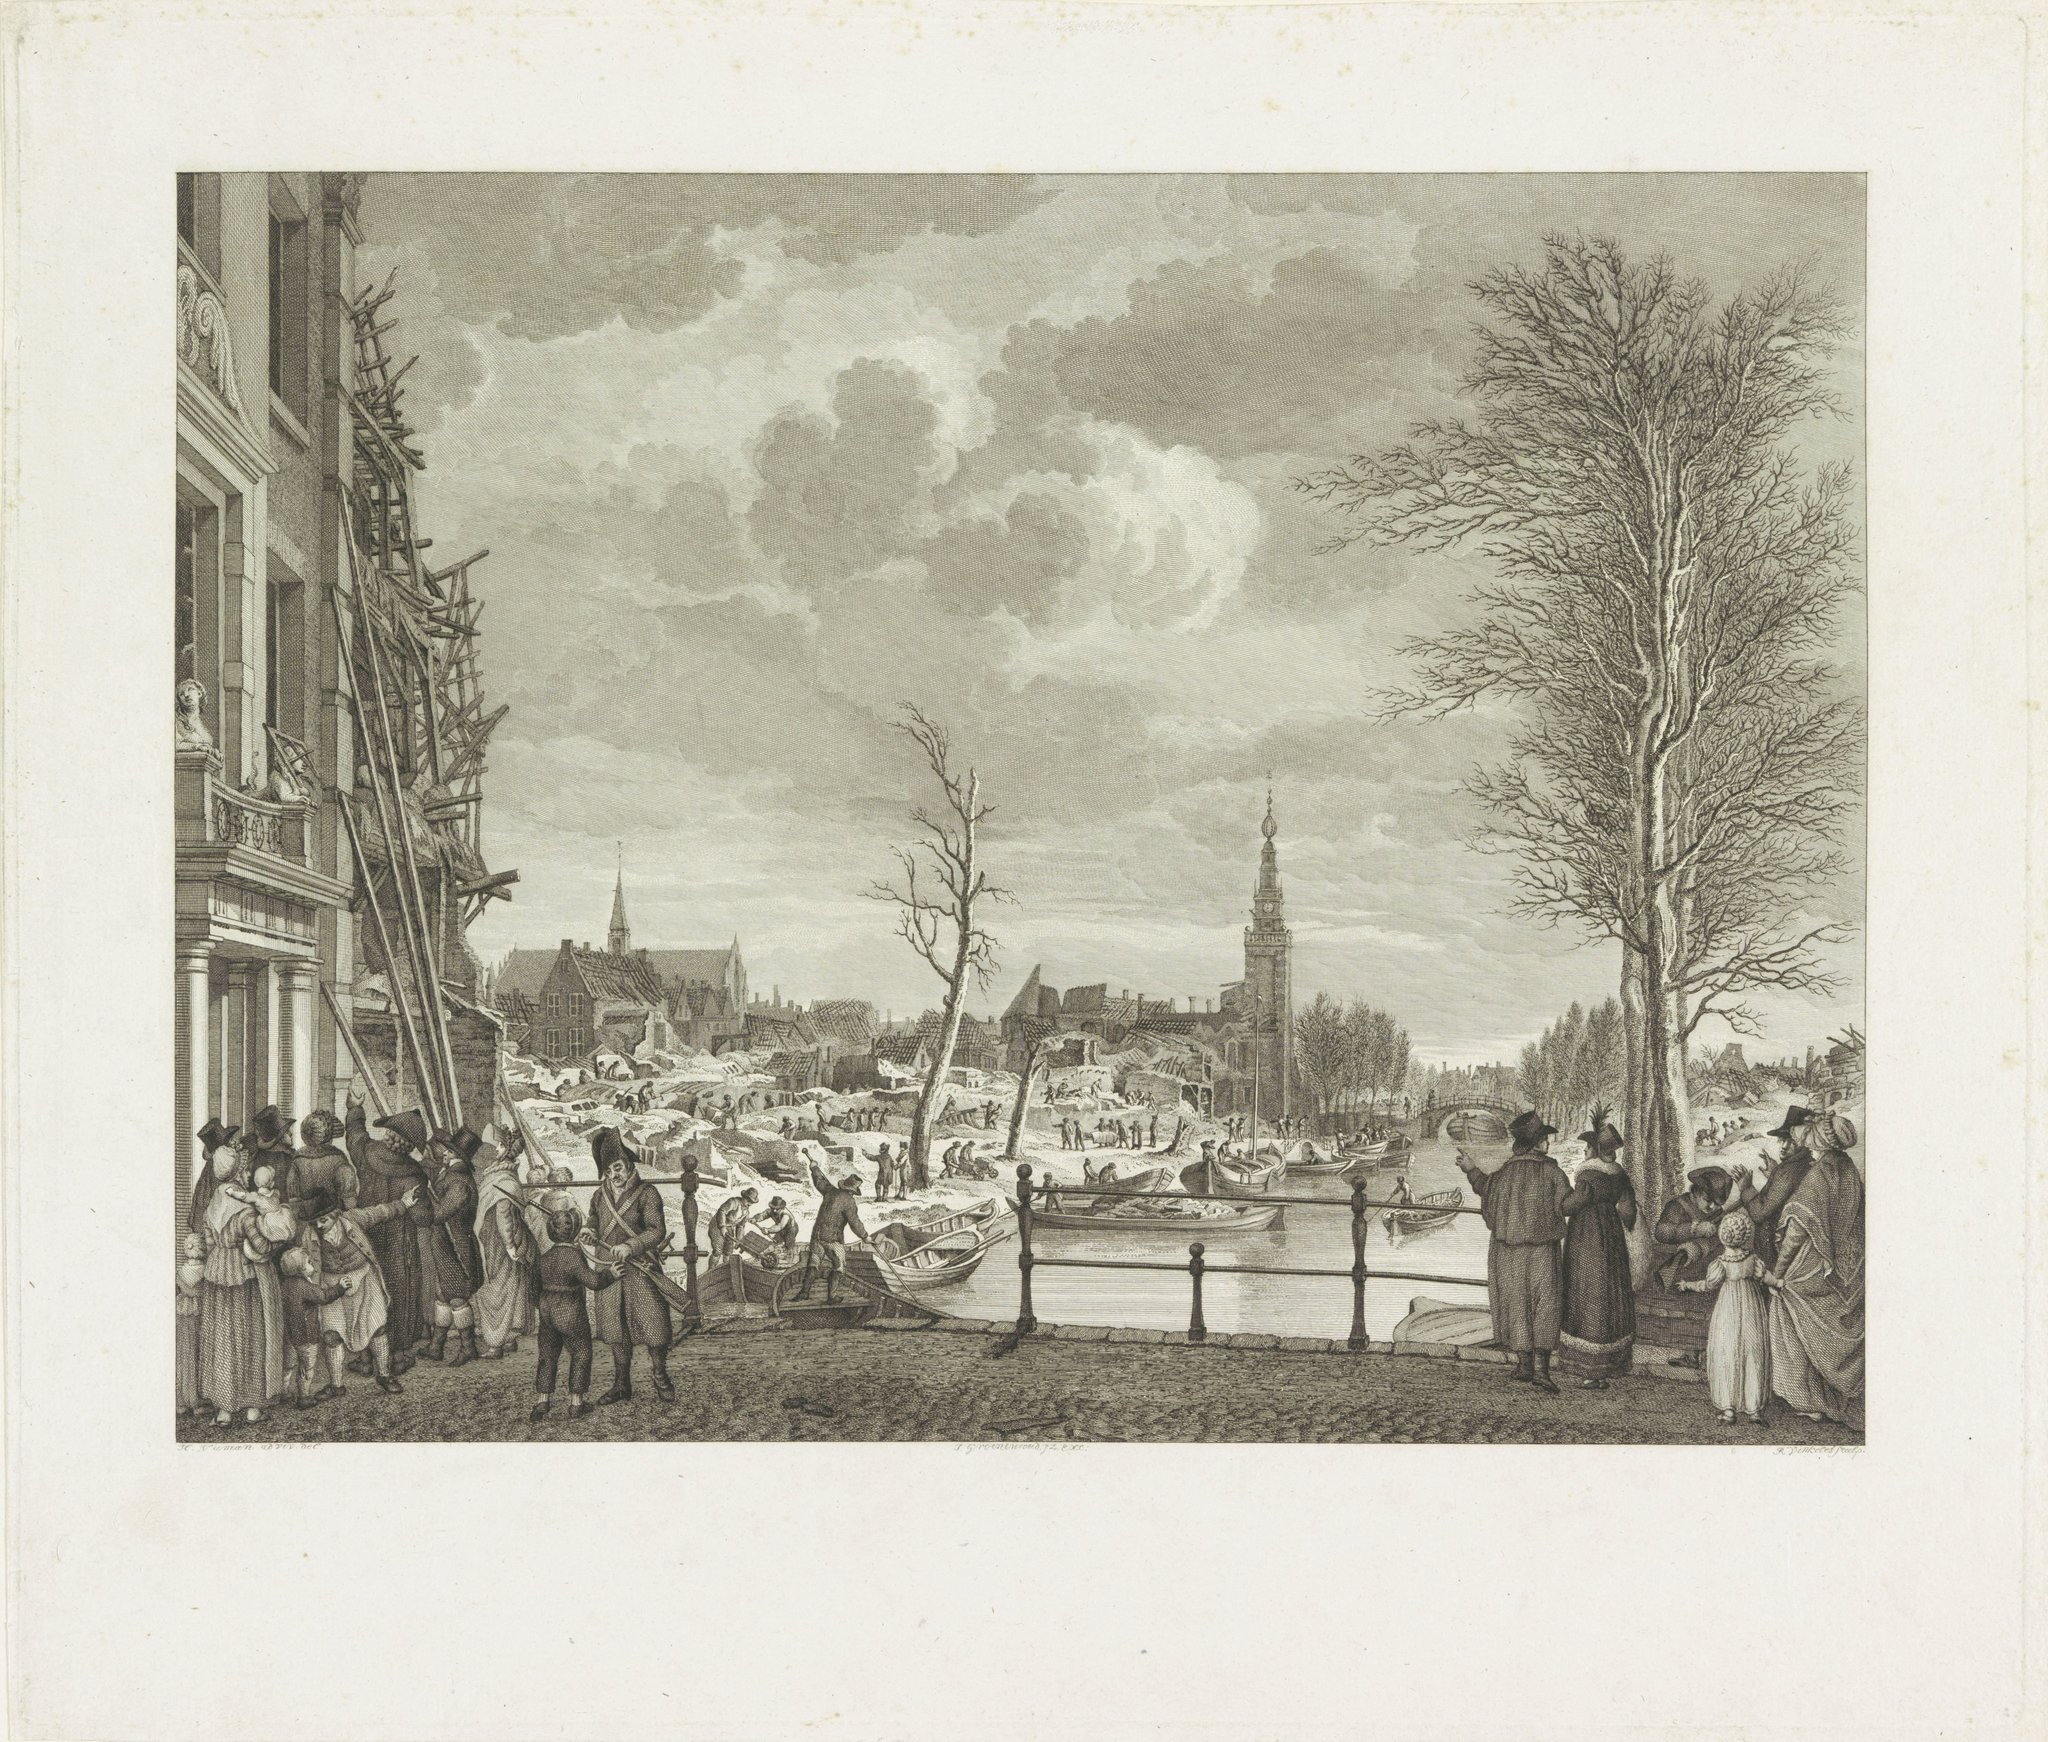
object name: print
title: Herstelwerk op het Rapenburg na de ramp, 1807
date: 1807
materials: paper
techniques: engraving, etching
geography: leiden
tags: gunpowder disaster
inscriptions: collector's mark: Lugt 2228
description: Gezicht vanaf de Nieuwsteegbrug op de herstelwerkzaamheden in het verwoeste gebied na de buskruitramp op het Steenschuur, een gracht in het verlengde van het Rapenburg, te Leiden op 12 januari 1807. Links op de voorgrond het huis van schepen J.W. van Noort, op de achtergrond in het midden de Saaihal.